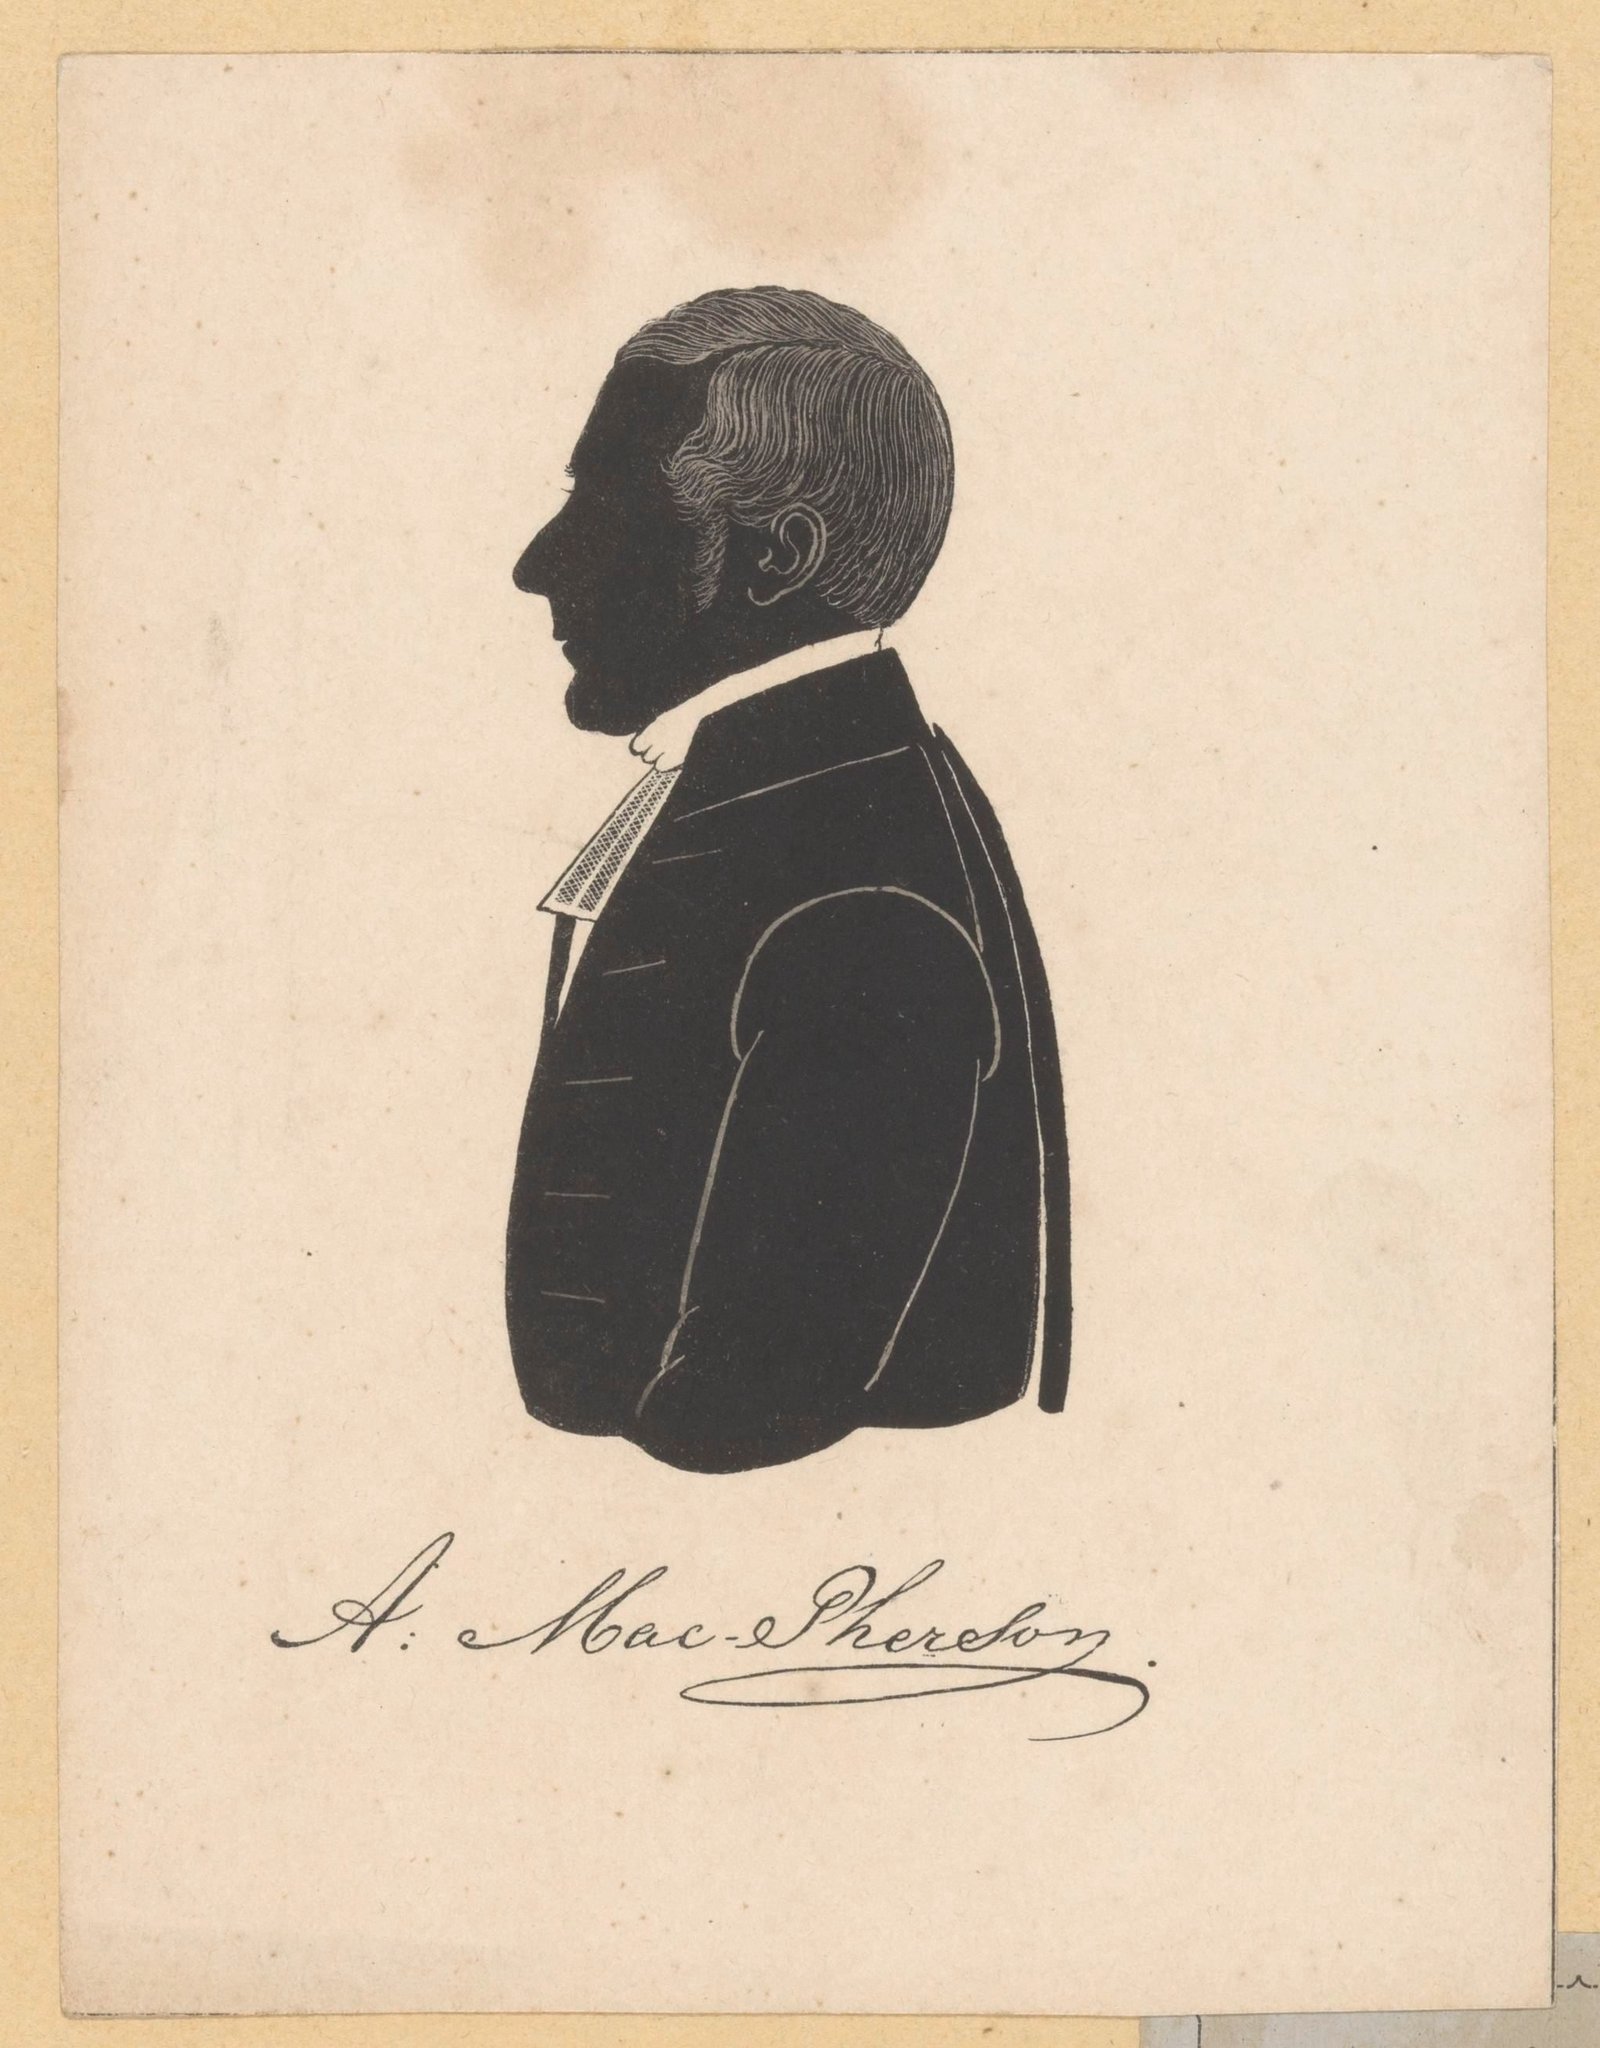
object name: print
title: Silhouetportret van Anthony MacPherson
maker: pieter barbiers (iv)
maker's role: painter, print maker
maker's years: 1798-1848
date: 1809-1848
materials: paper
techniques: hand coloring, lithograph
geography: netherlands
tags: historical persons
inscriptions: collector's mark: Lugt 2228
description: Onder het portret de signatuur van de geportretteerde.